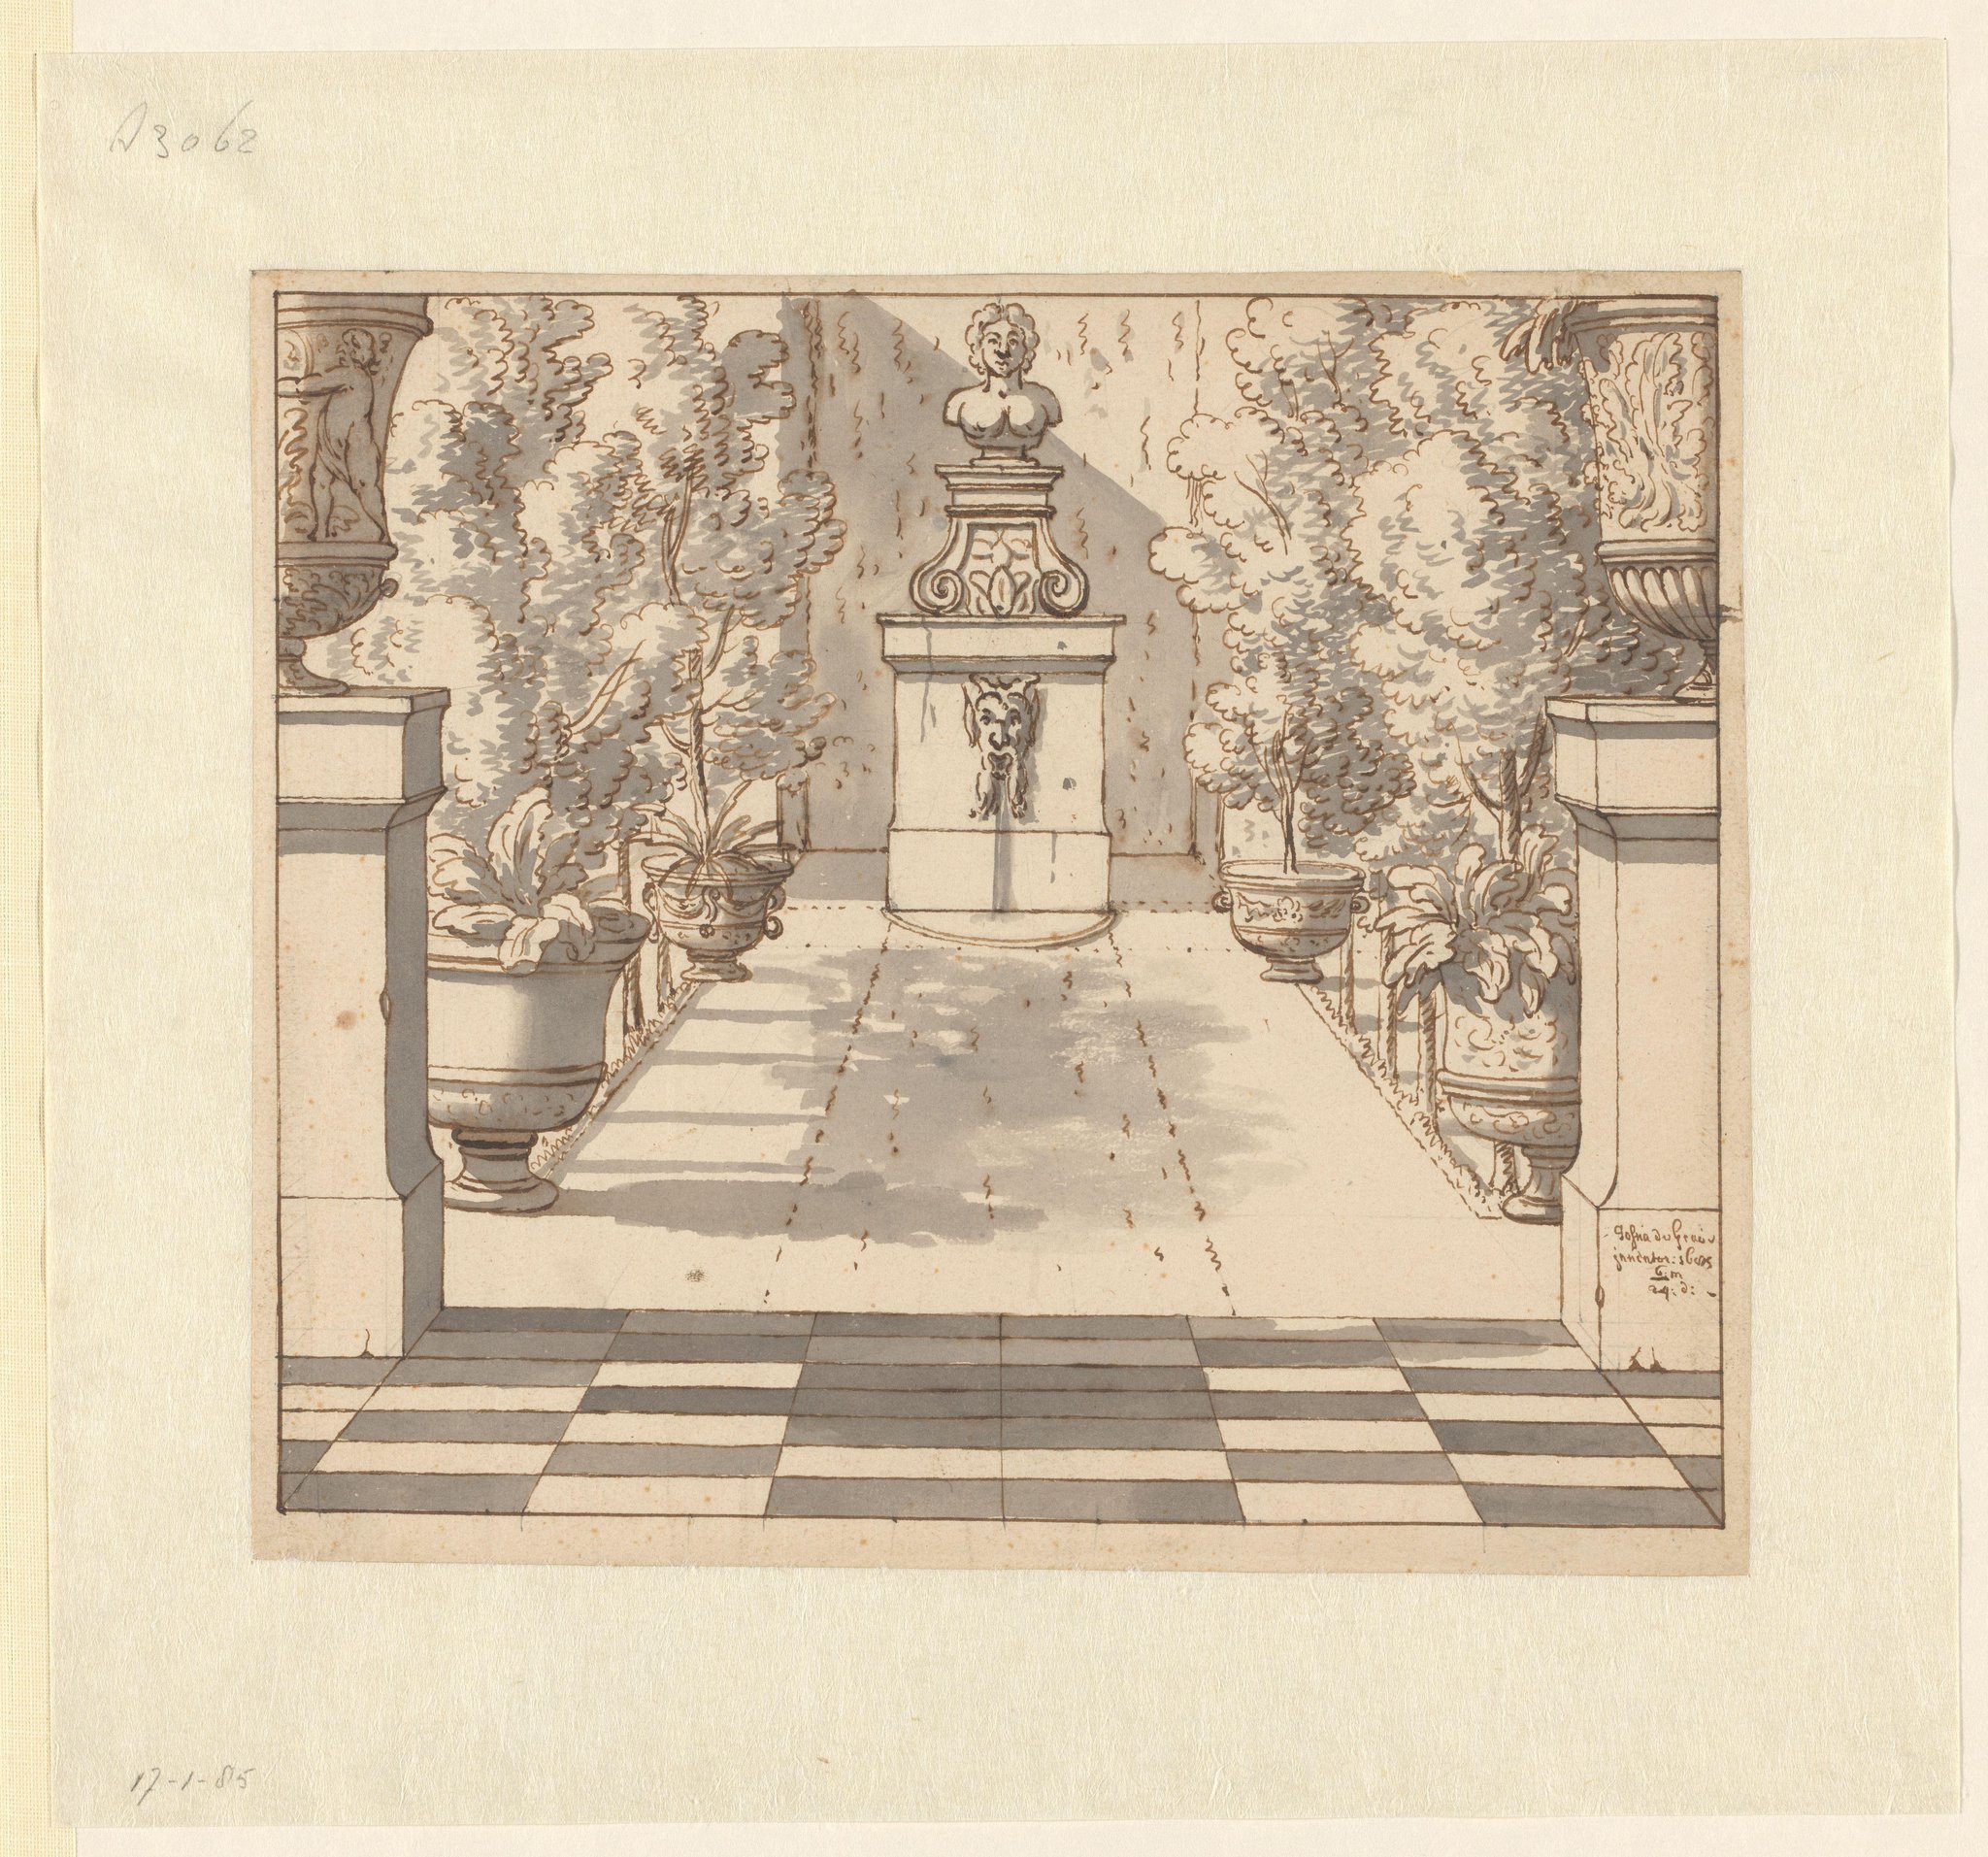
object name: drawing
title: View of a Fountain in an Italianate Garden / verso: Alternative Sketch of the Upper Section of the Fountain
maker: josua de grave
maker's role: draughtsman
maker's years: 1645-1712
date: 1685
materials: ink, paper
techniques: brush, pen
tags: garden ornaments, water-works in garden